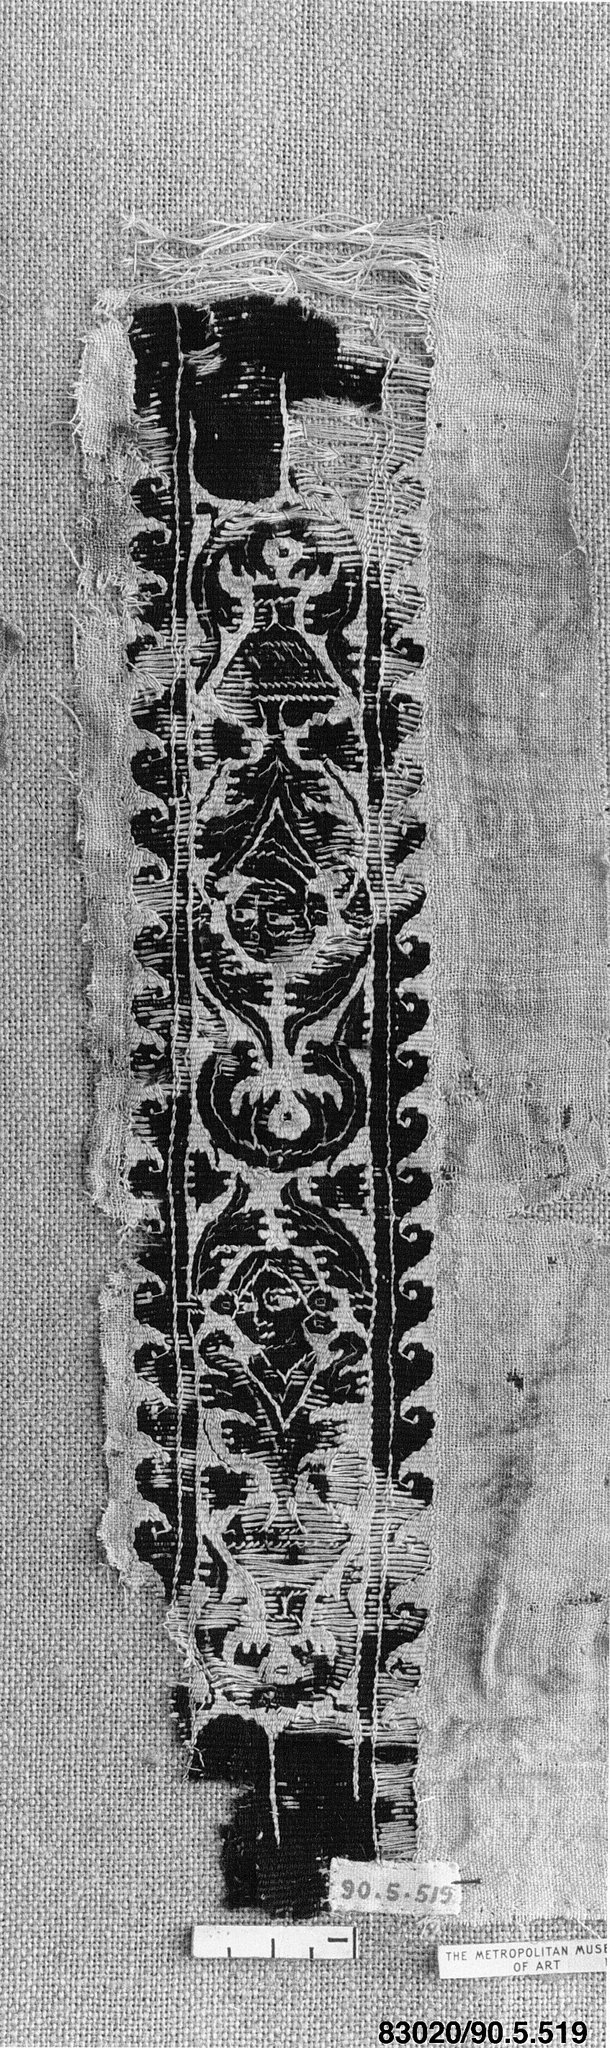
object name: textile fragment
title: Fragment of a Sleeve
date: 201-400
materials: linen, wool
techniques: weave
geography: egypt